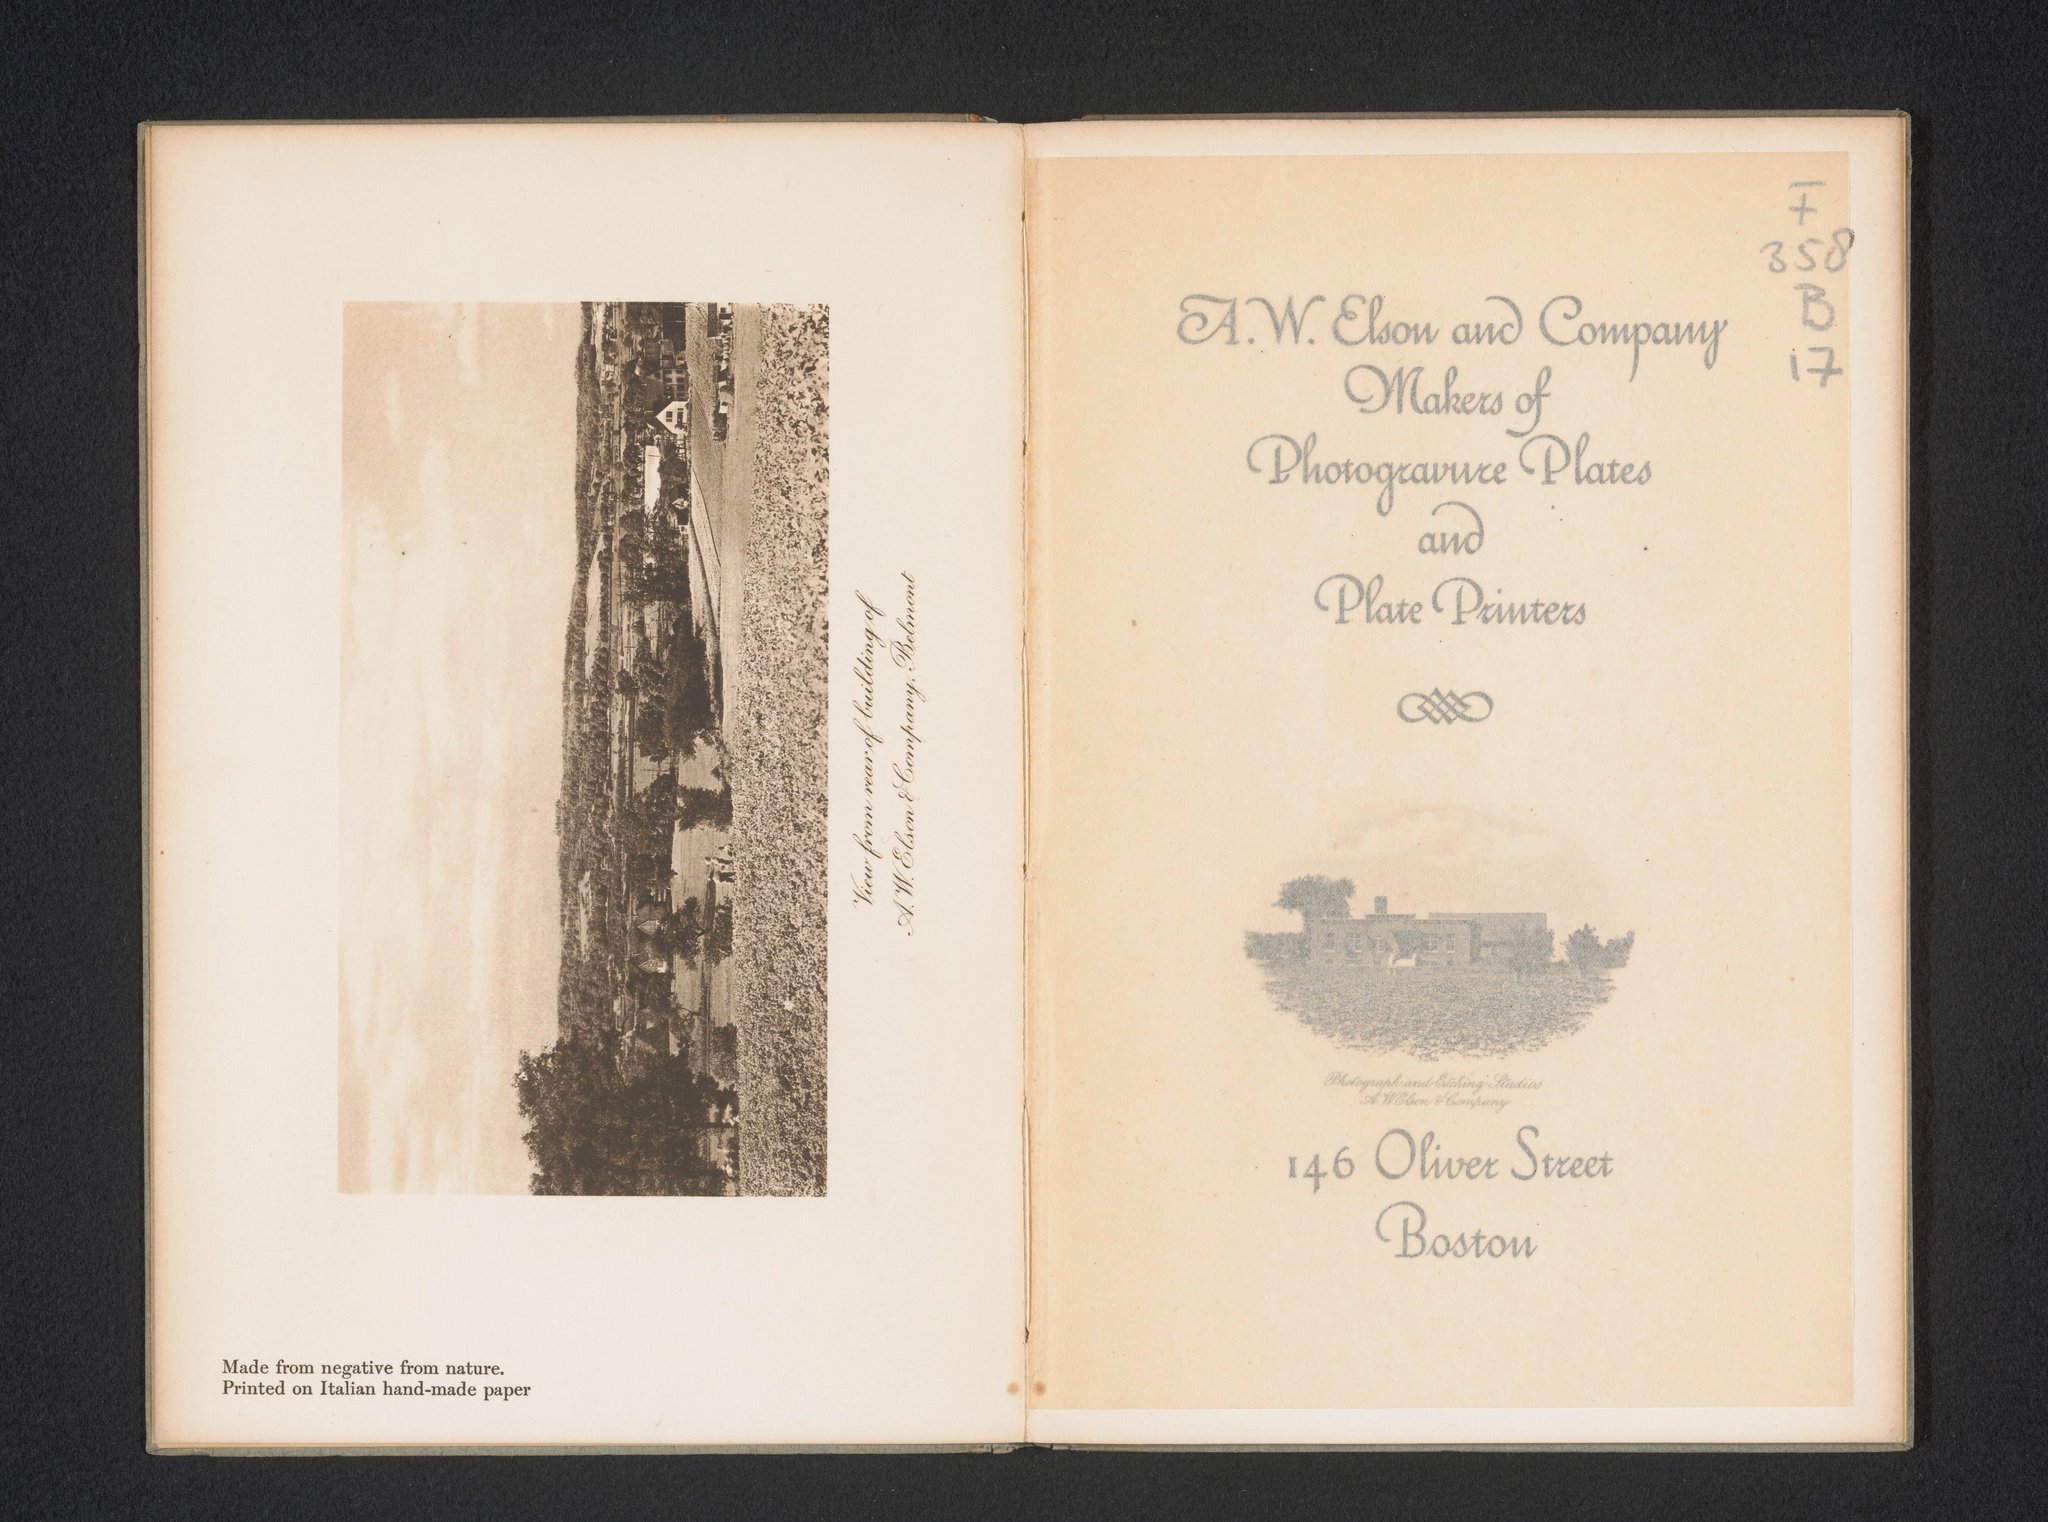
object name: page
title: Landschap nabij Belmont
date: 1903-1908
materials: paper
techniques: photograph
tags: landscapes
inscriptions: inscription: ‘Made from negative from nature./ Printed on Italian hand-made paper’